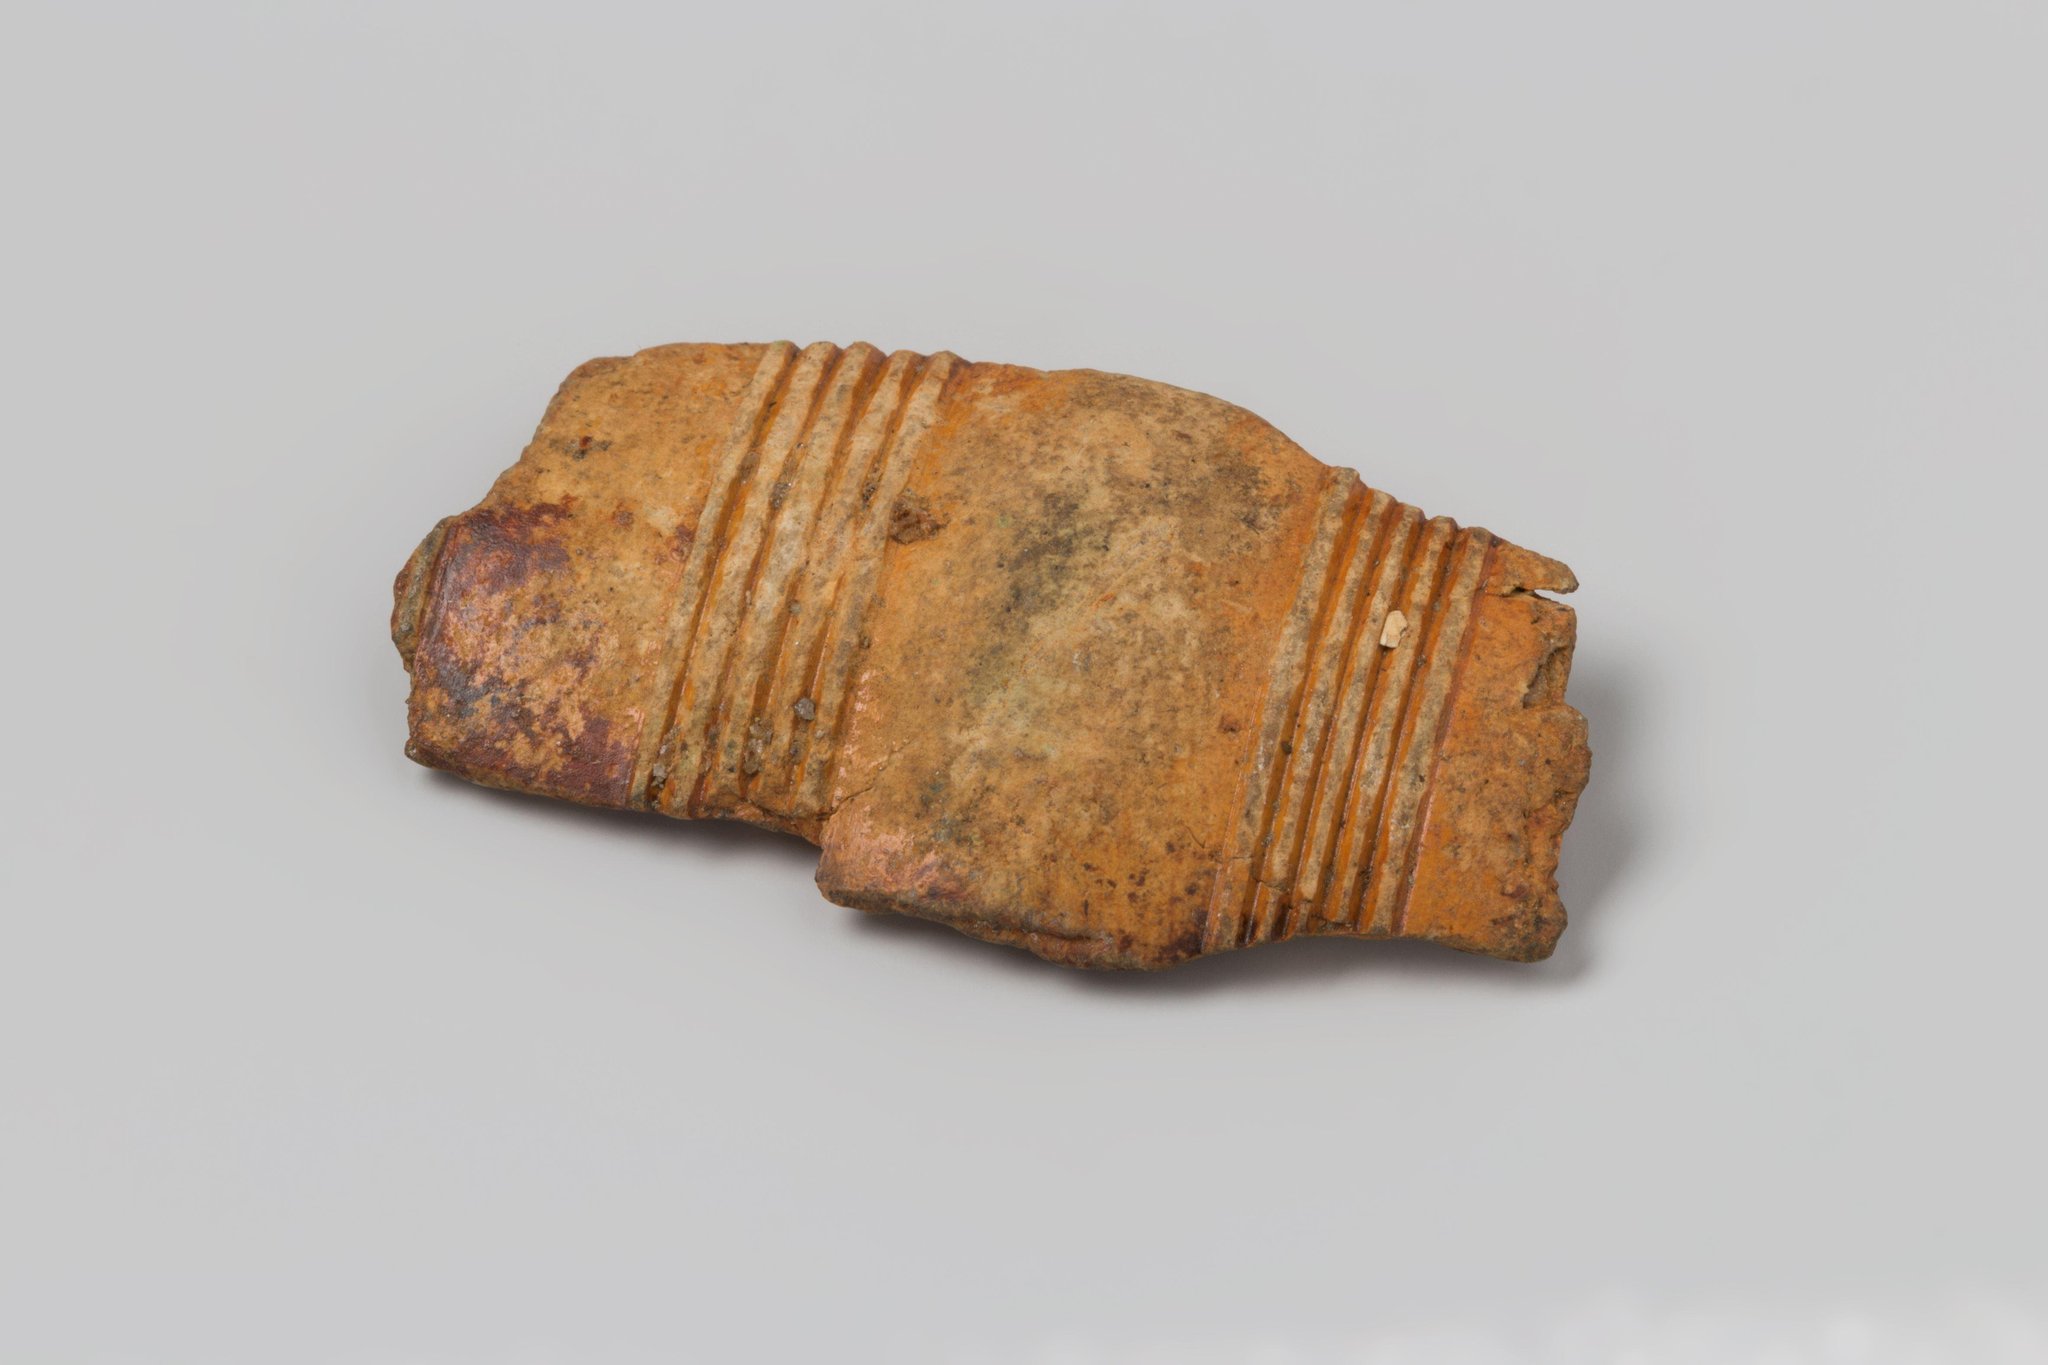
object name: pot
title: Fragment pot uit het wrak van de Oost-Indiëvaarder Hollandia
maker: Anonymous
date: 1700-1743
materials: bone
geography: netherlands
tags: verenigde oostindische compagnie, hollandia (schip), annet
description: Pot; fragm of circular body, upper rim internally threaded, relieved exterior decoration of 2 linear bands and 1 convex plain band.